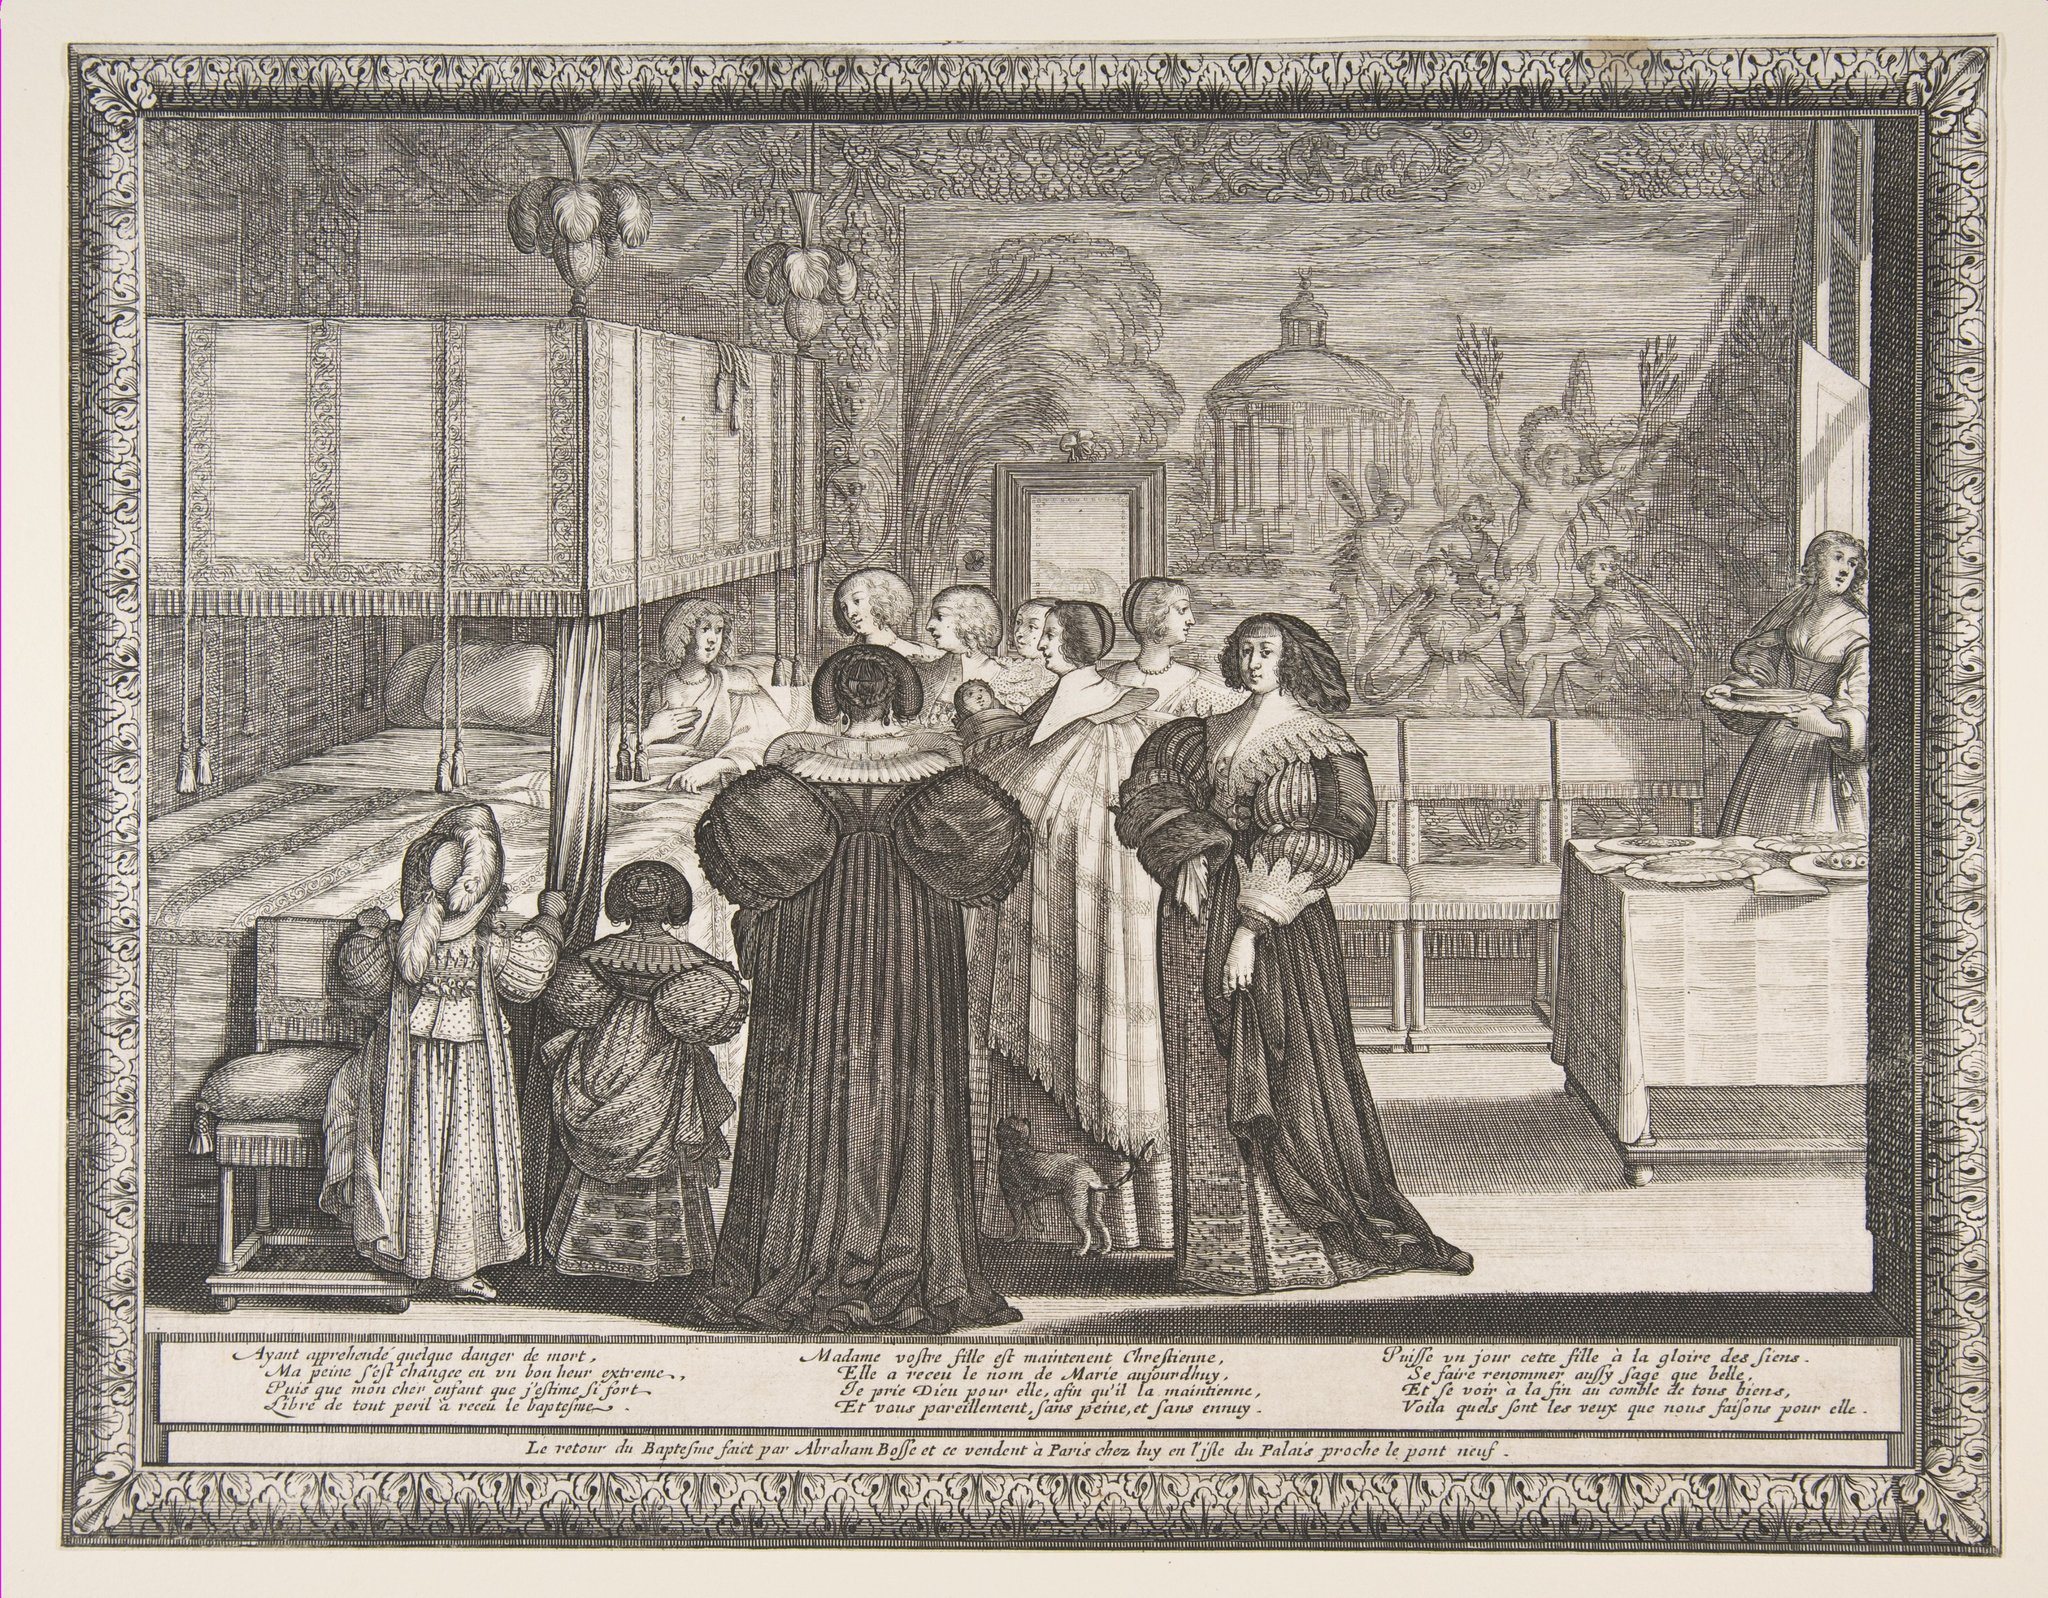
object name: print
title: Return from the Christening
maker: abraham bosse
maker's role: artist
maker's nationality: french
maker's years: 1602-1676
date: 1633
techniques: etching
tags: infants,women,female nudes,birth